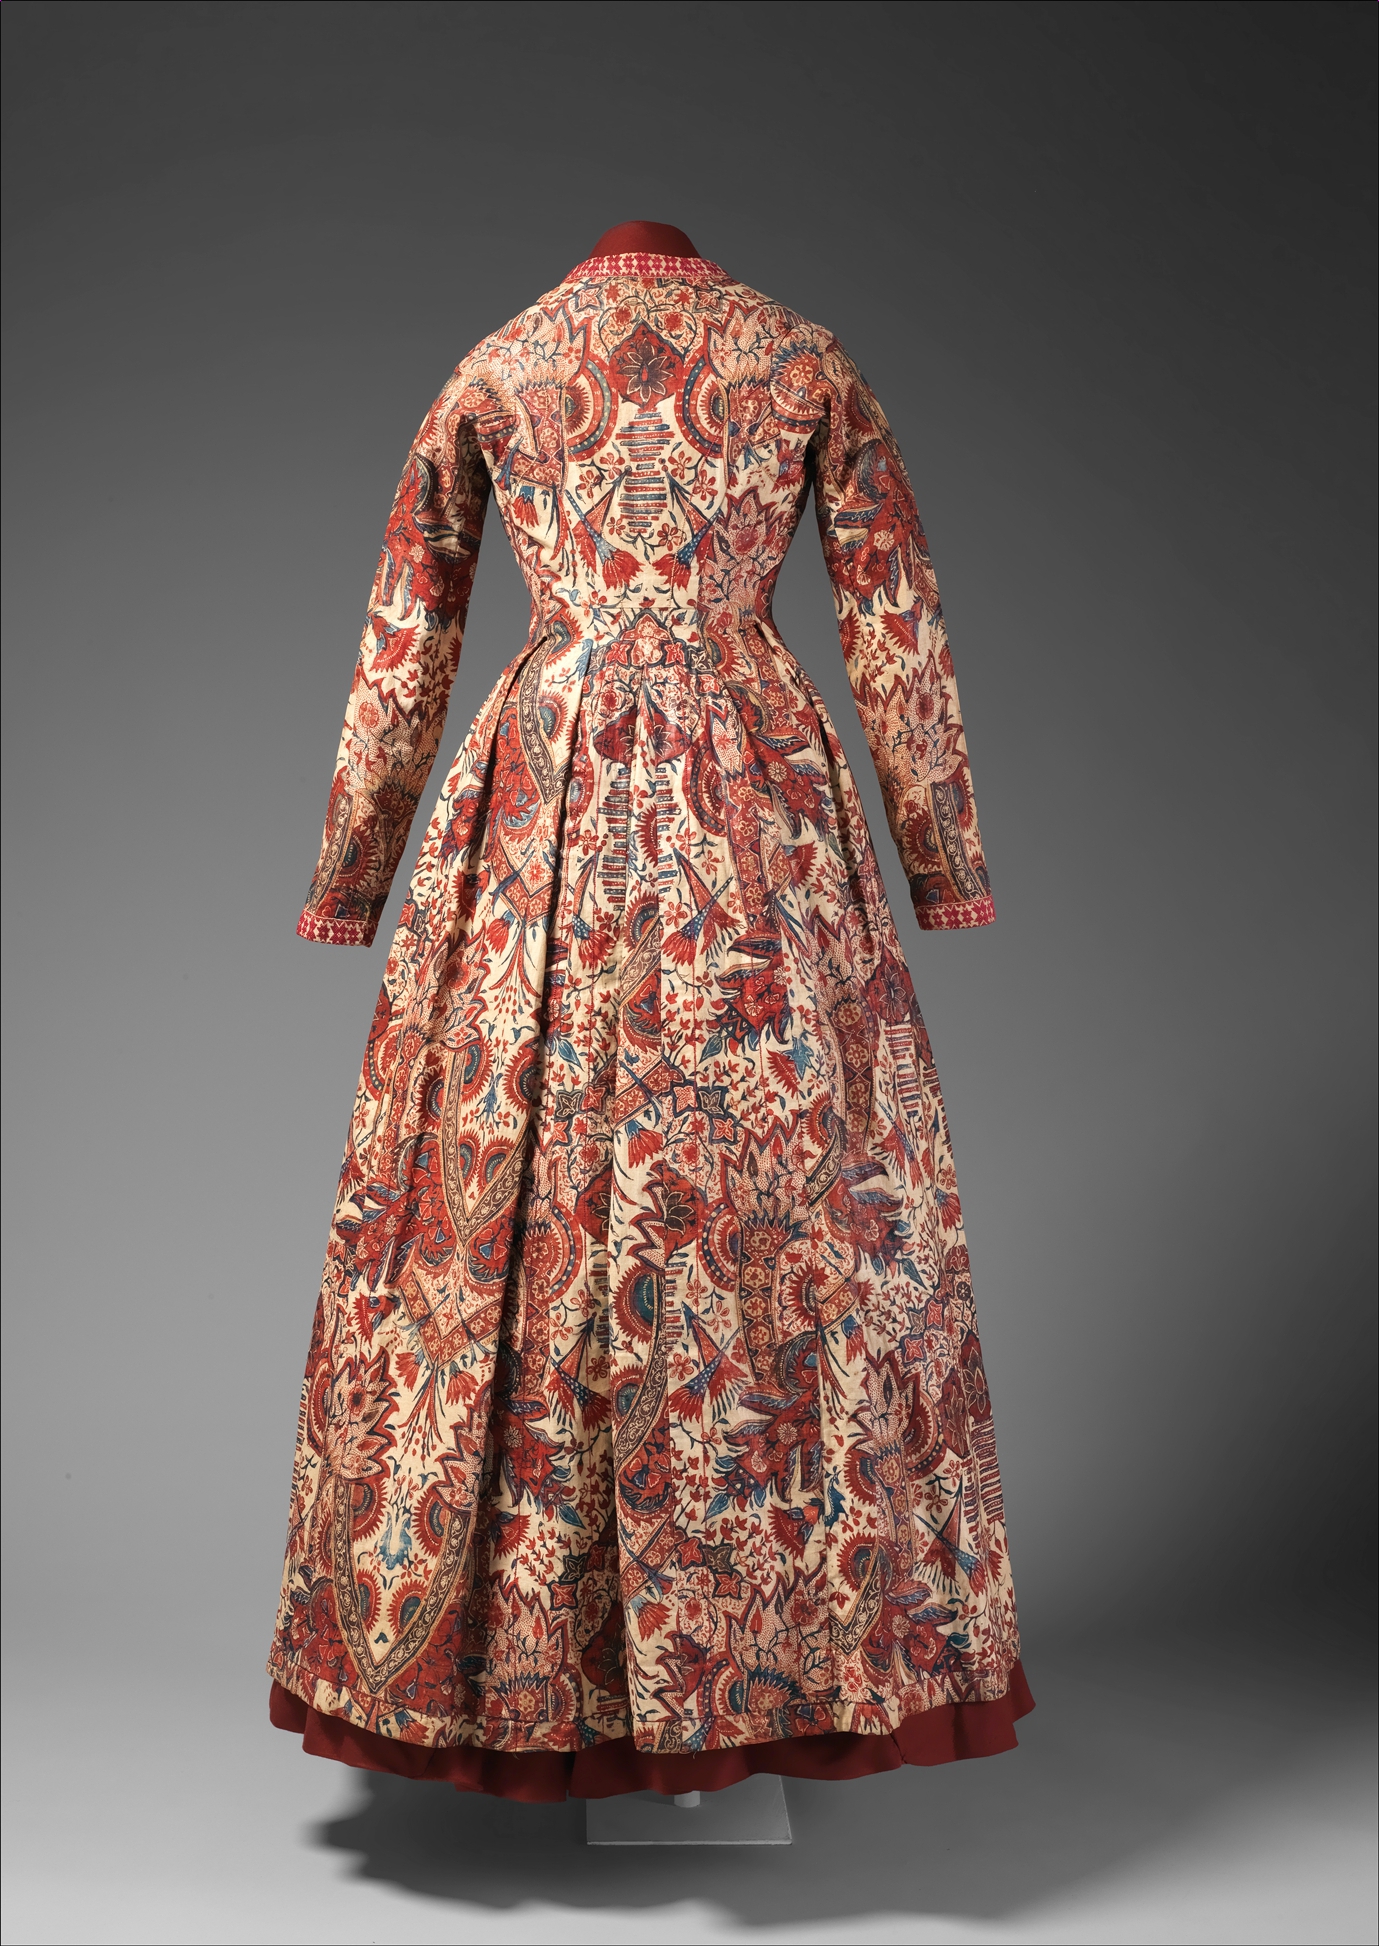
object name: wentke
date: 1734-1766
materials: cotton, linen